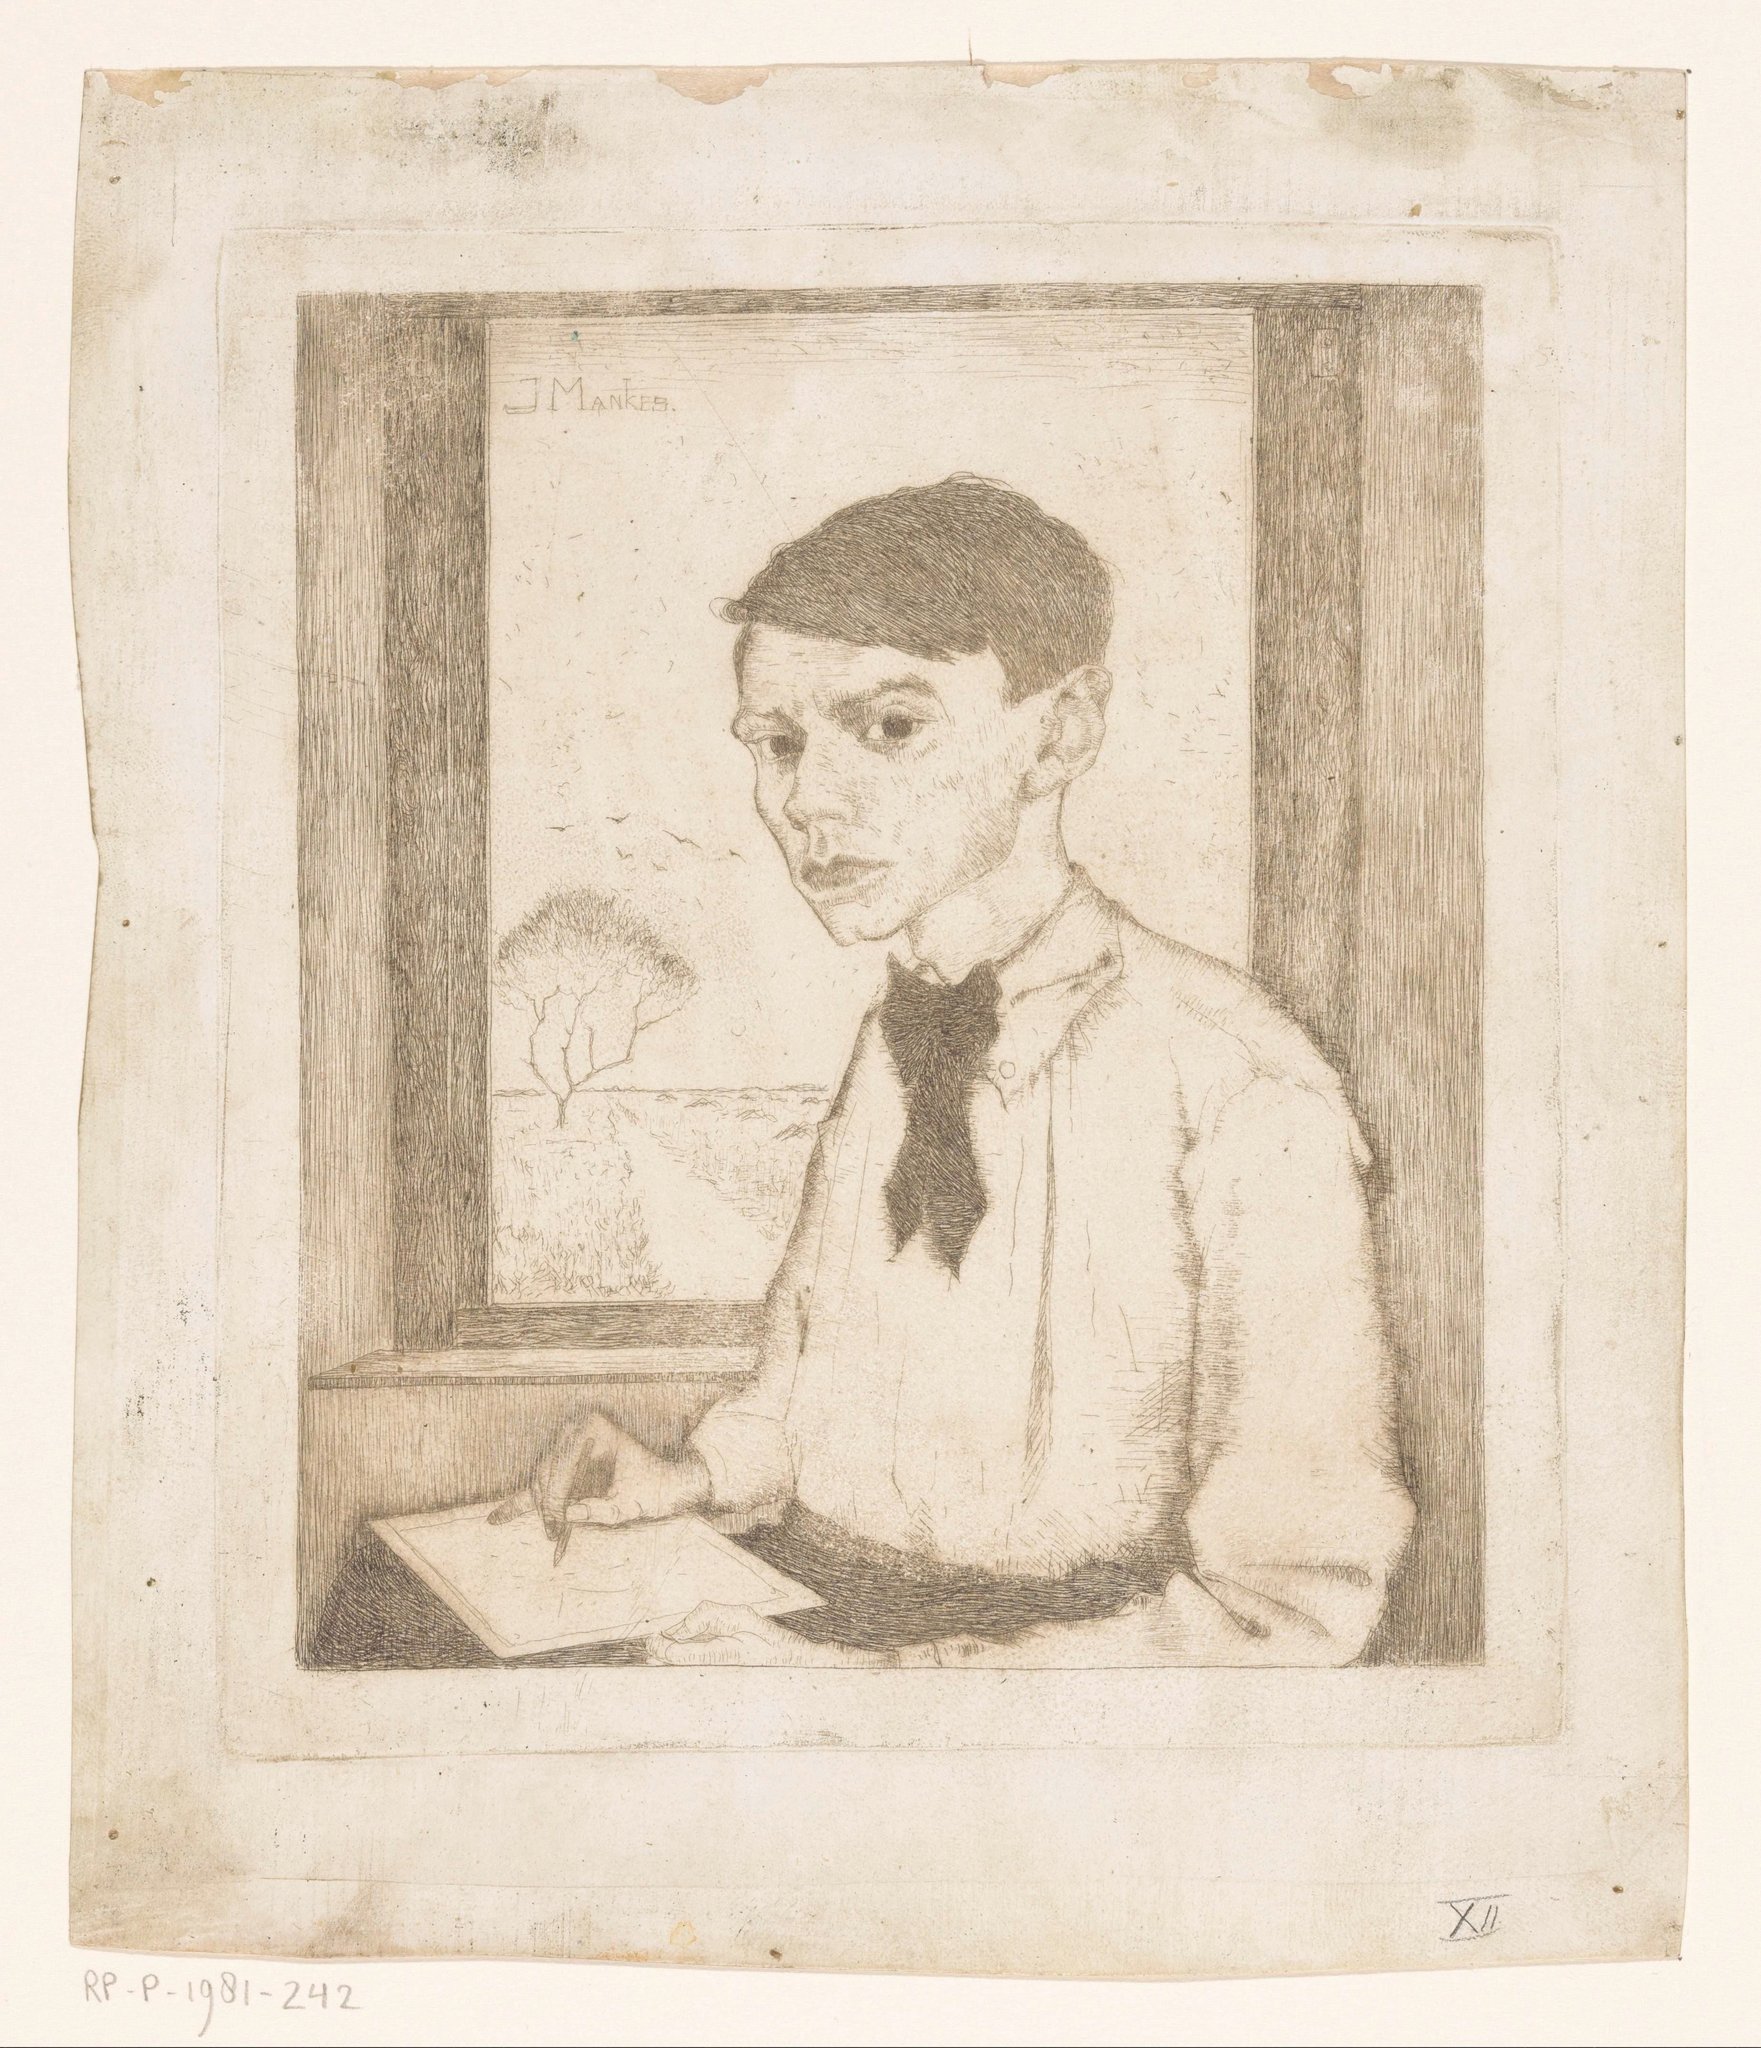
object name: print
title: Zelfportret tekenend bij een raam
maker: jan mankes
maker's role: draughtsman, painter, print maker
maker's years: 1889-1920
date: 1913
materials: paper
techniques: etching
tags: draughtsman, jan mankes, drawing, neck-gear ~ clothing (with name), portrait, self-portrait of artist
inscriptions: collector's mark: Lugt 2228, number: ‘XII’